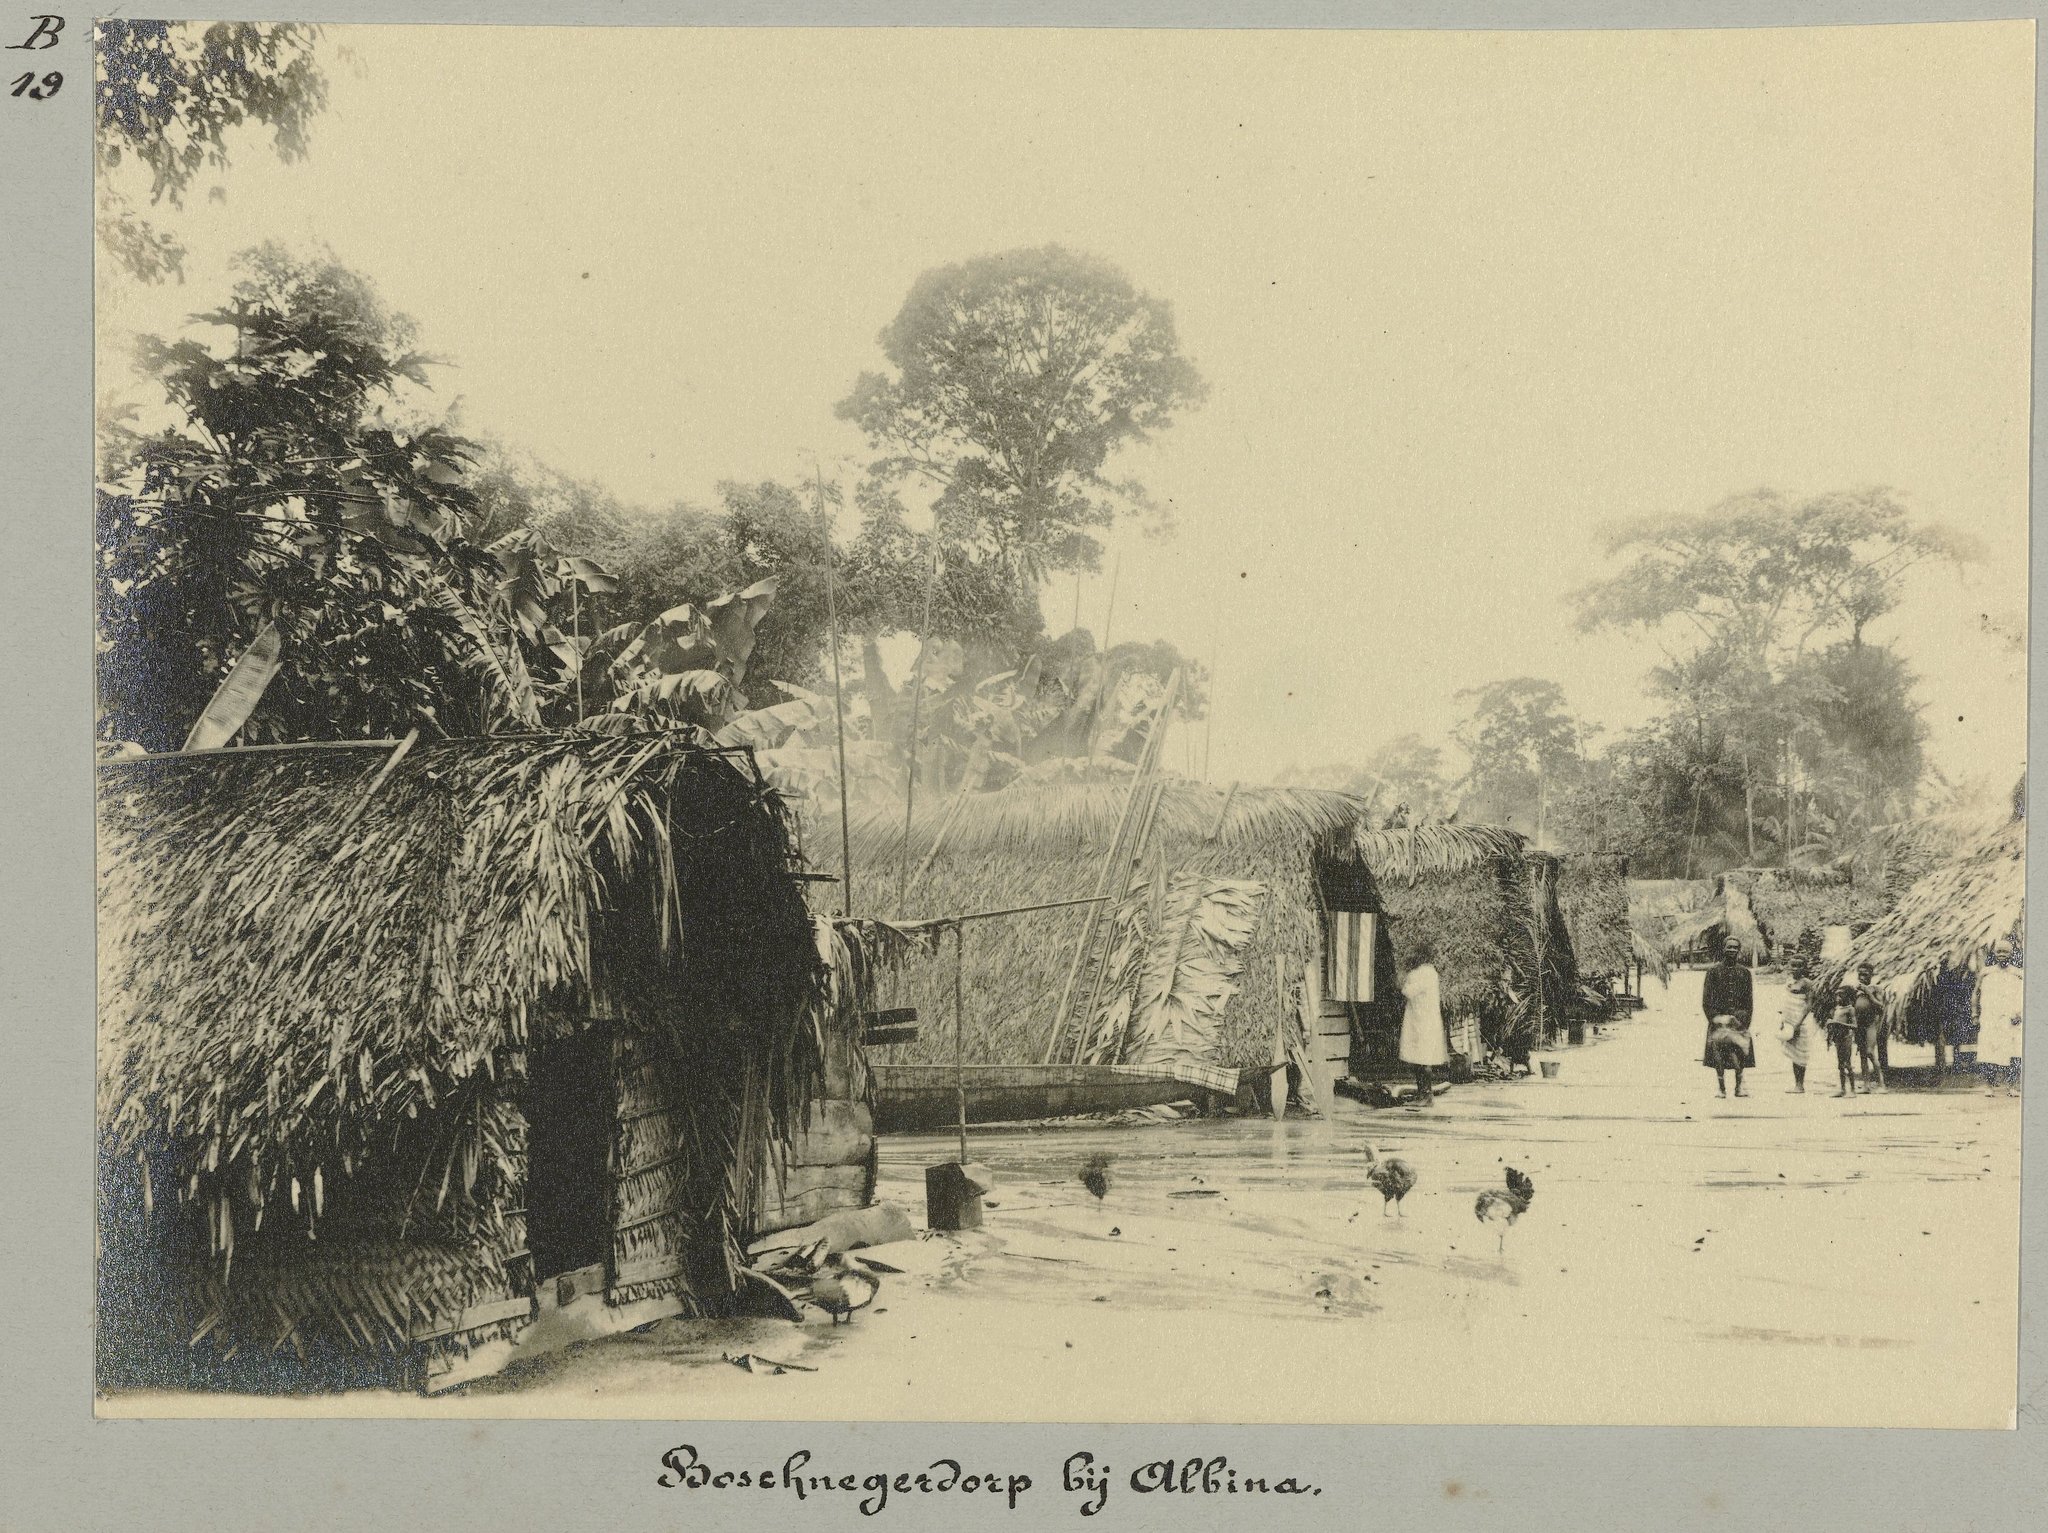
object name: photograph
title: Marrondorp bij Albina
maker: hendrik doijer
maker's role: engineer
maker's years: 1863-1925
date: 1903-1910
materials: photographic support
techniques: gelatin silver print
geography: suriname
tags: suriname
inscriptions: inscription: ‘B.19 / Boschnegerdorp bij Albina.’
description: Gezicht op een dorp van Surinaamse Marrons bij Albina. Onderdeel van het fotoalbum Souvenir de Voyage (deel 2), over het leven van de familie Doijer in en rond de plantage Ma Retraite in Suriname in de jaren 1903-1910.